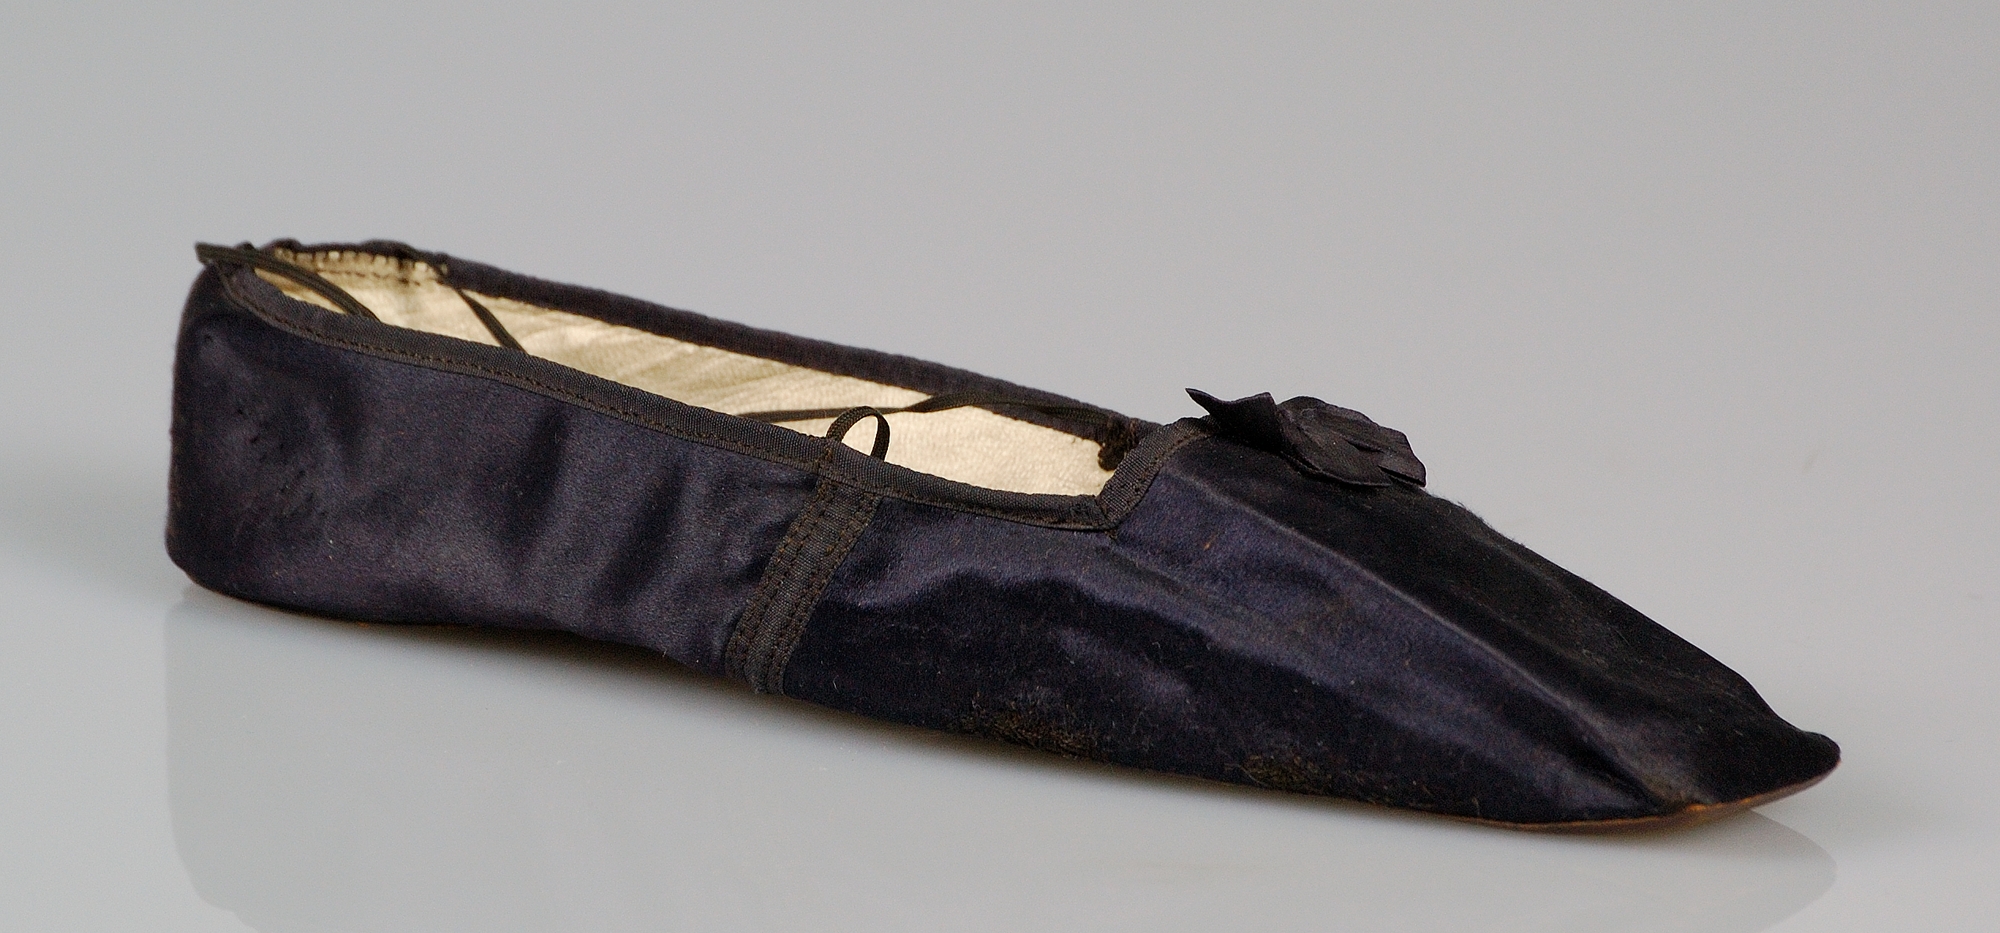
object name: evening slipper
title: Evening slippers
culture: british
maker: east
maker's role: maker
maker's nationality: british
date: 1830-1839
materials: silk